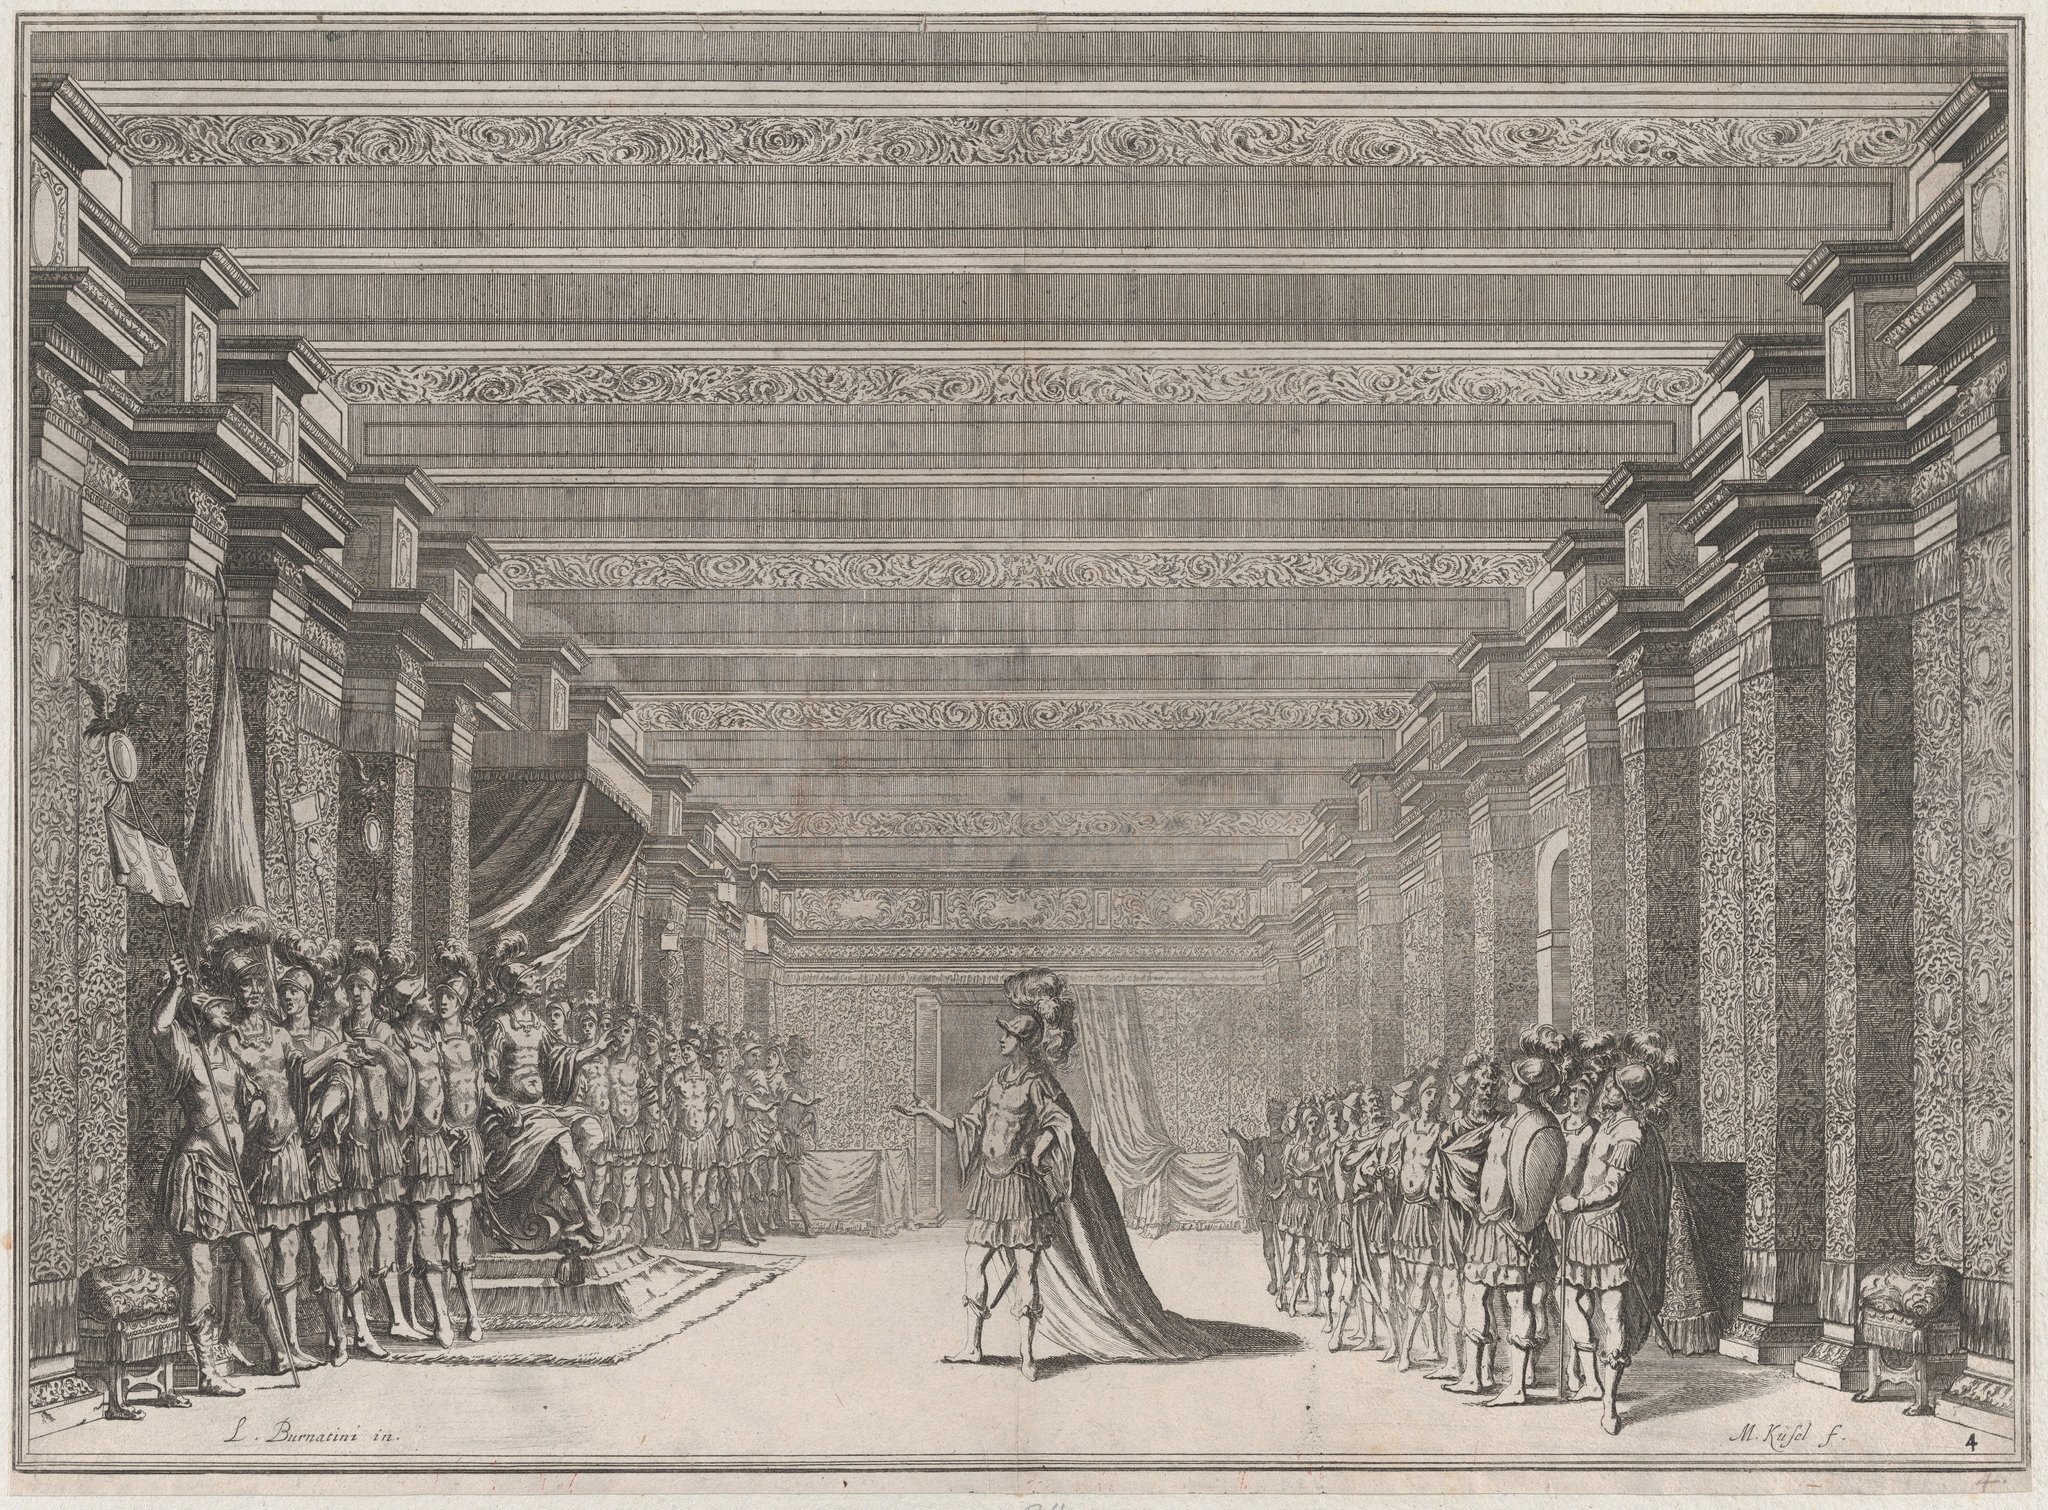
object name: print, fete, ornament architecture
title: Throne room with a man in classical armor standing at center addressing a man seated on a throne at left; soldiers lined on either side of the room; set design from 'Il Fuoco Eterno'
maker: mathäus küsel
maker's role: artist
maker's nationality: german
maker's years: 1621-1682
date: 1674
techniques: etching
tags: soldiers,men